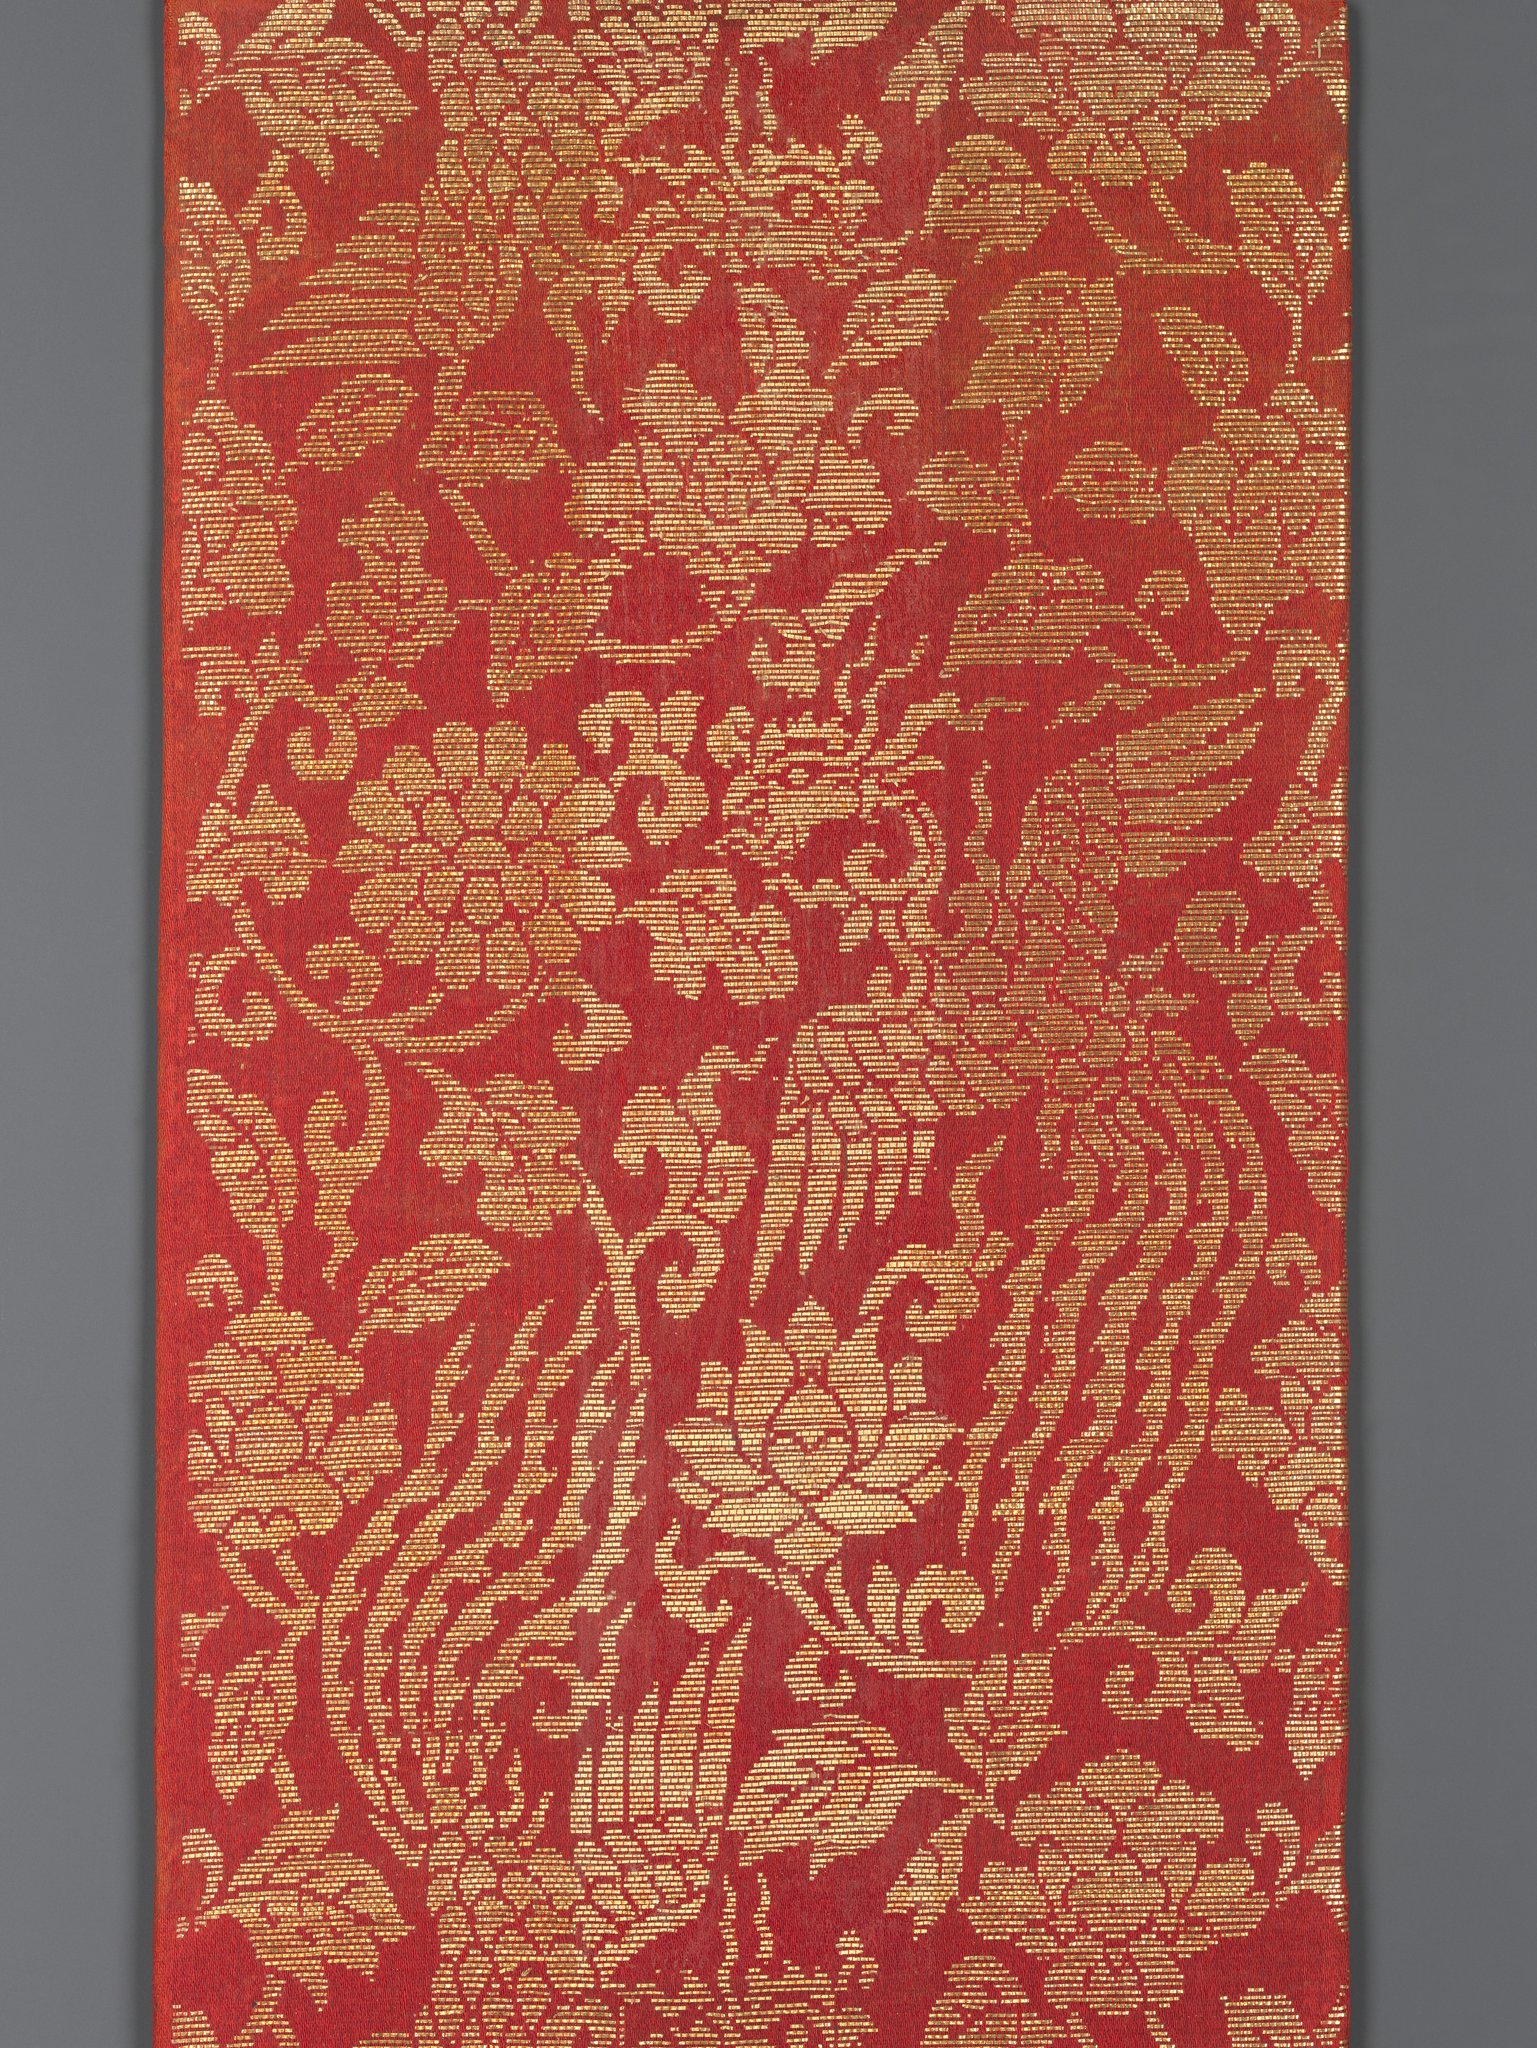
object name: sutra cover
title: Sutra cover with phoenixes amid flowers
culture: chinese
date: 1501-1600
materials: metal thread, silk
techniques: patterning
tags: phoenix,flowers